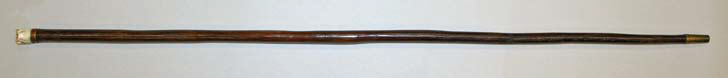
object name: cane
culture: american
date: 1880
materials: ivory